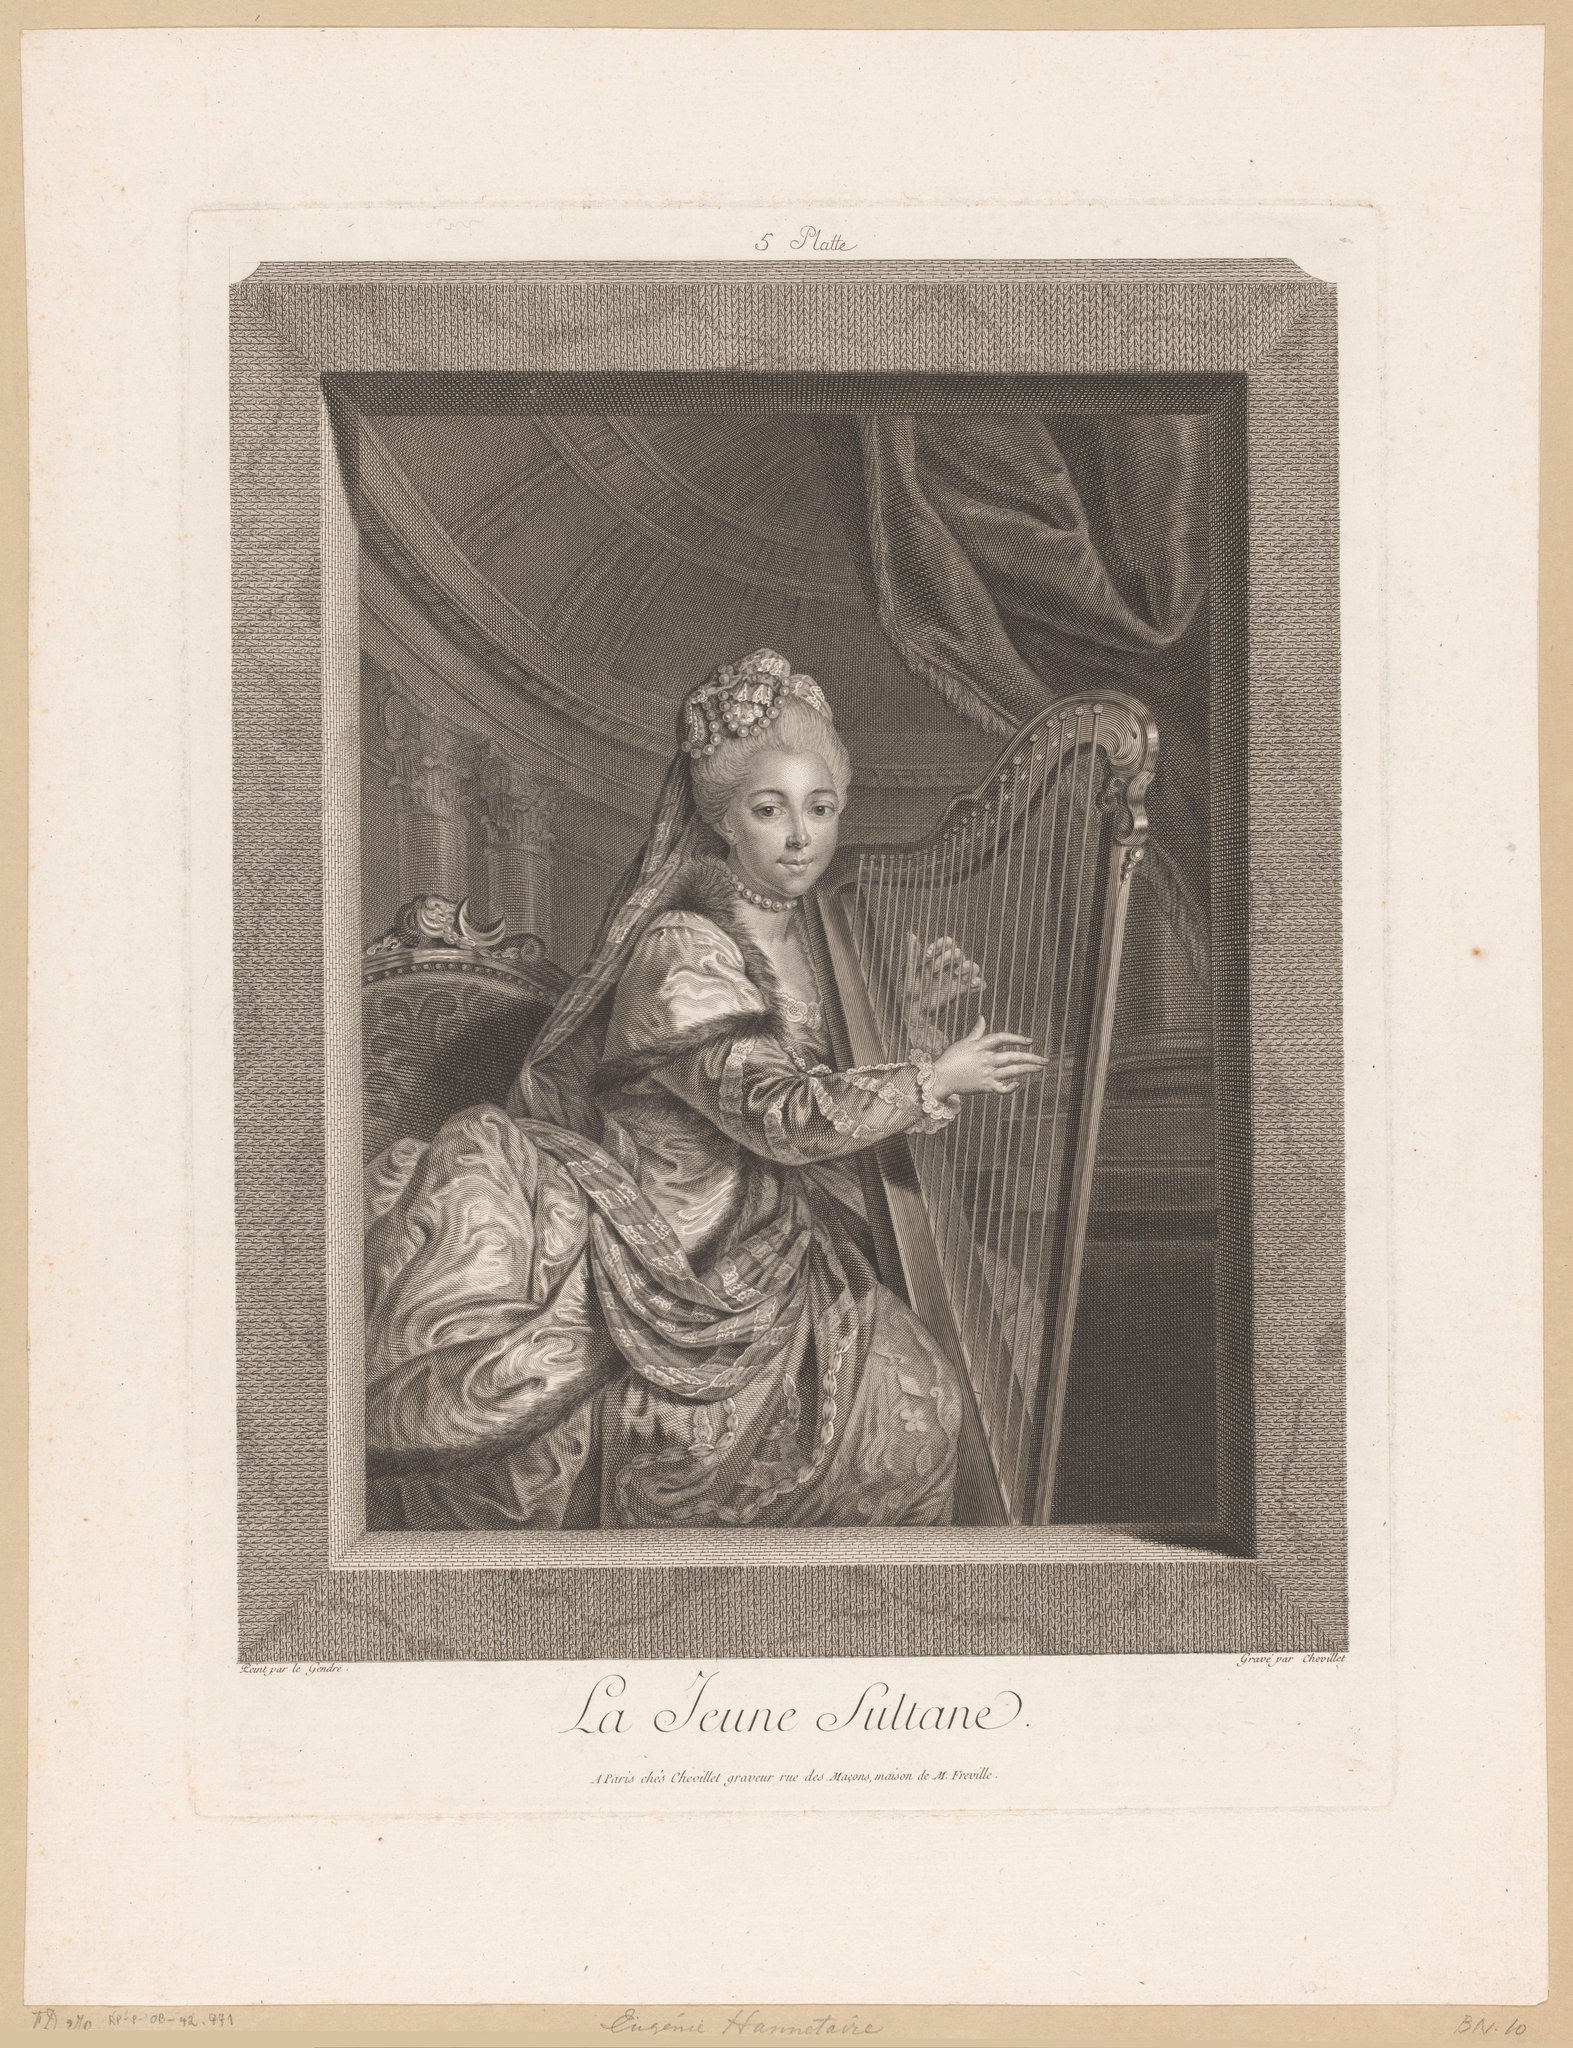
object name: print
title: La Jeune Sultane.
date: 1774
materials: paper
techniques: engraving, etching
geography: paris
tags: adolescent, young woman, maiden, harp